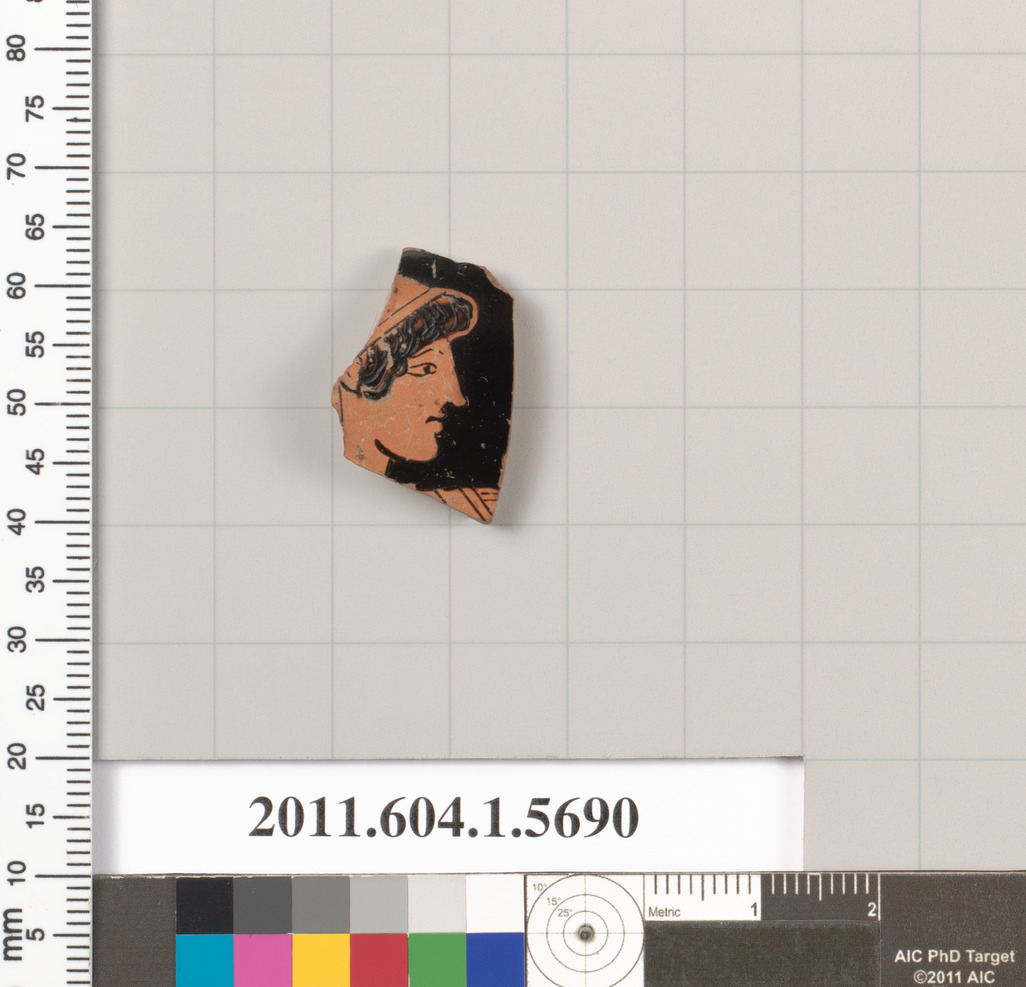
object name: kylix fragment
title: Terracotta fragment of a kylix (drinking cup)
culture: greek, attic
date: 475-451 BCE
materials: terracotta